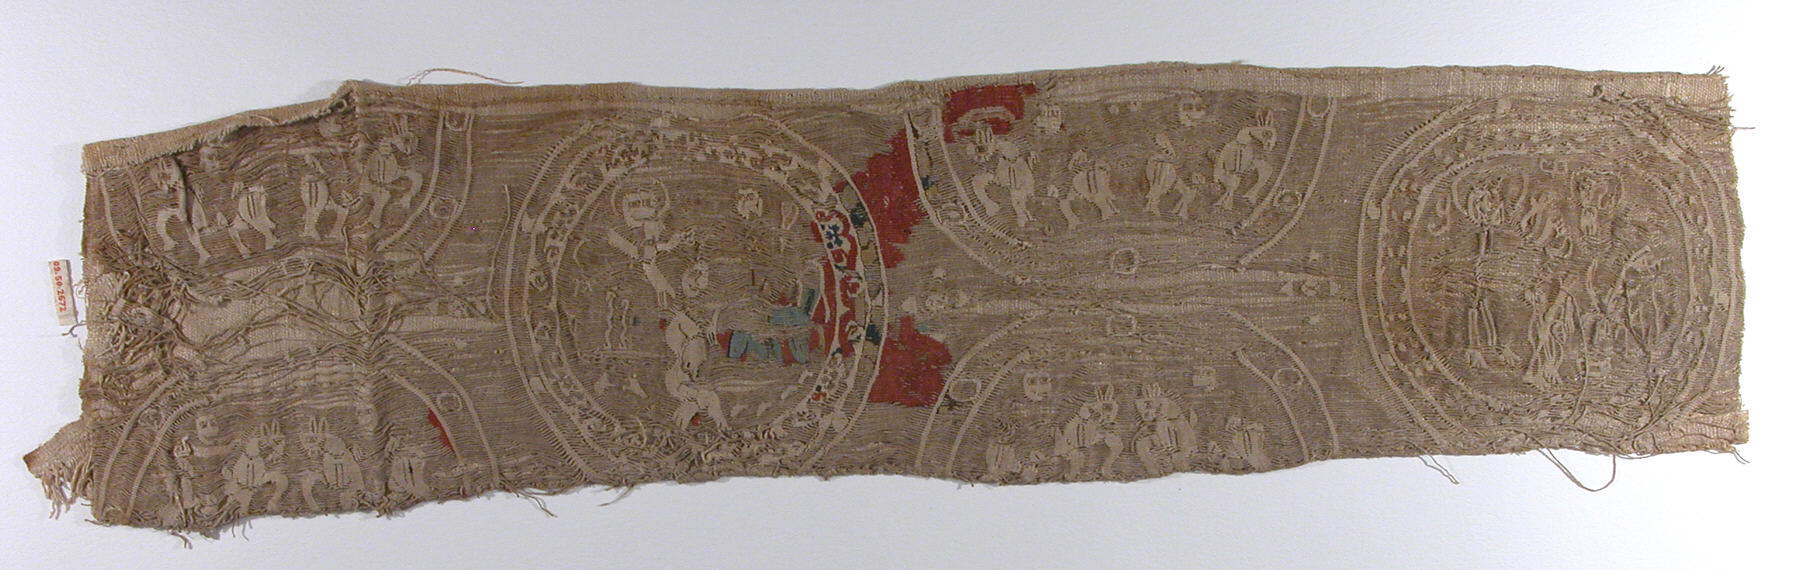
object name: fragment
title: Textile Fragment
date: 501-600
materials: linen, wool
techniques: weave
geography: egypt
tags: animals